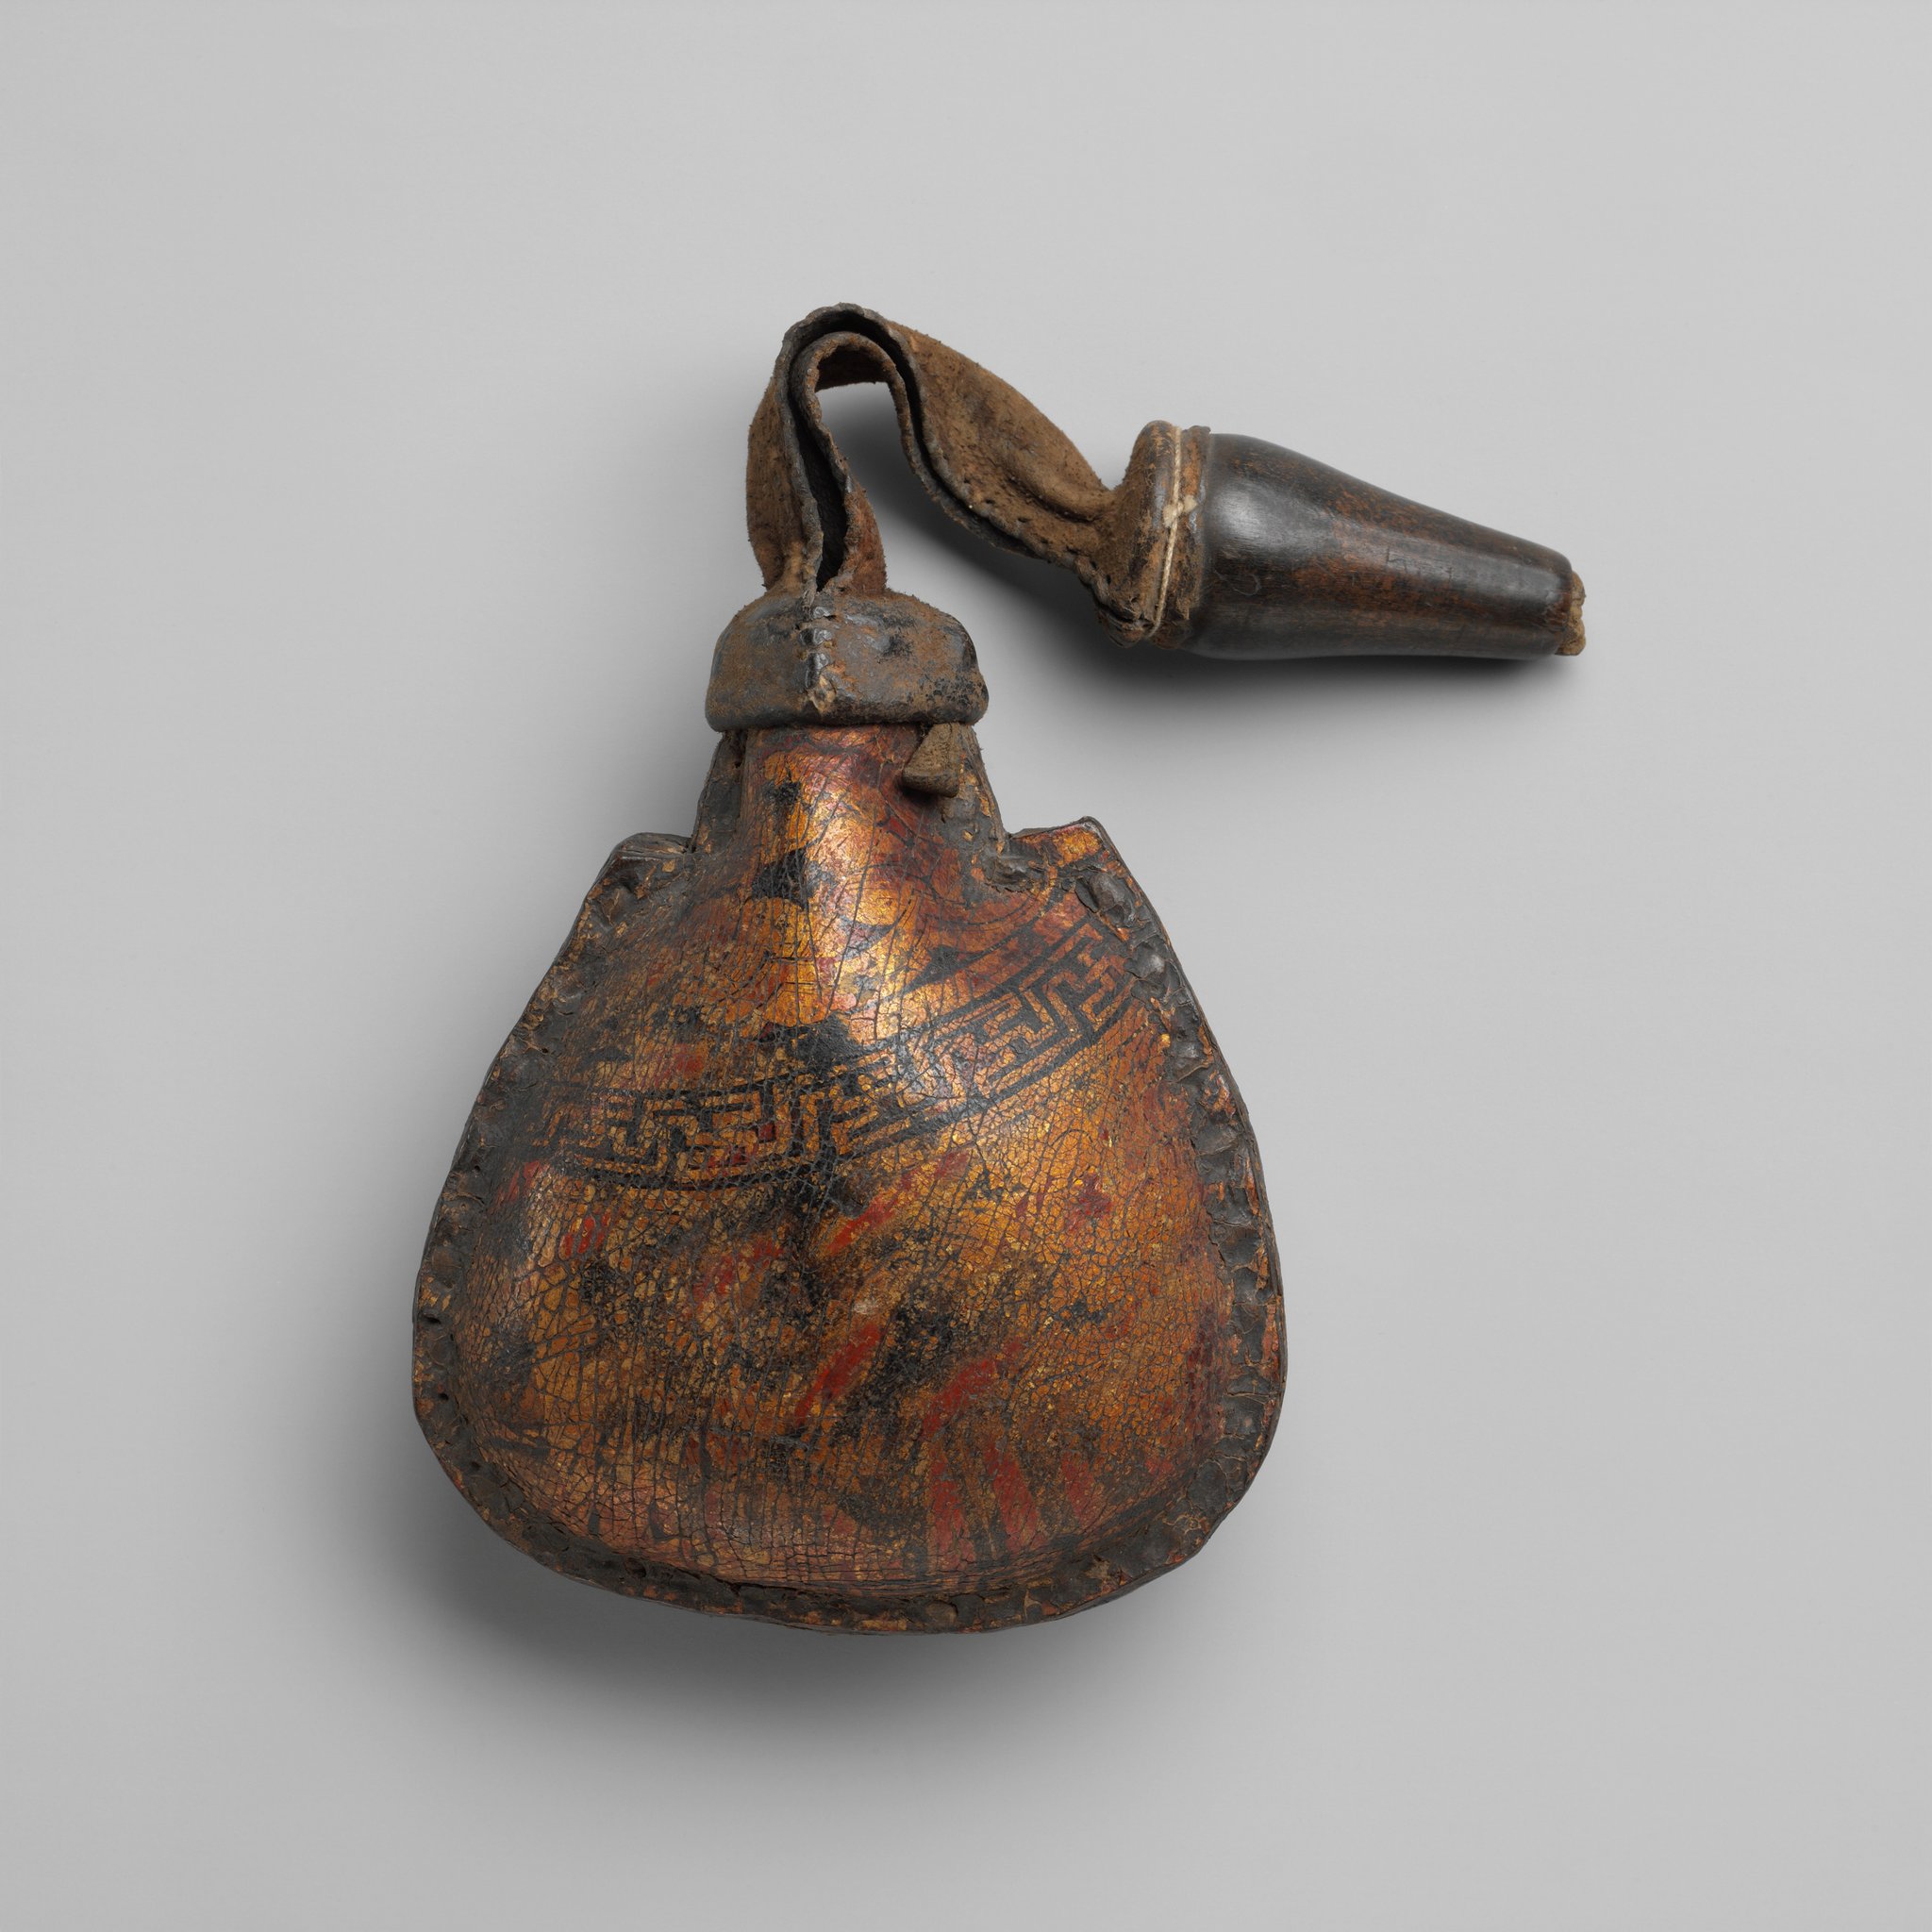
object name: powder flask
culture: mongolian or tibetan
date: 1501-1700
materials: gold, horn, leather, pigment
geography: mongolia